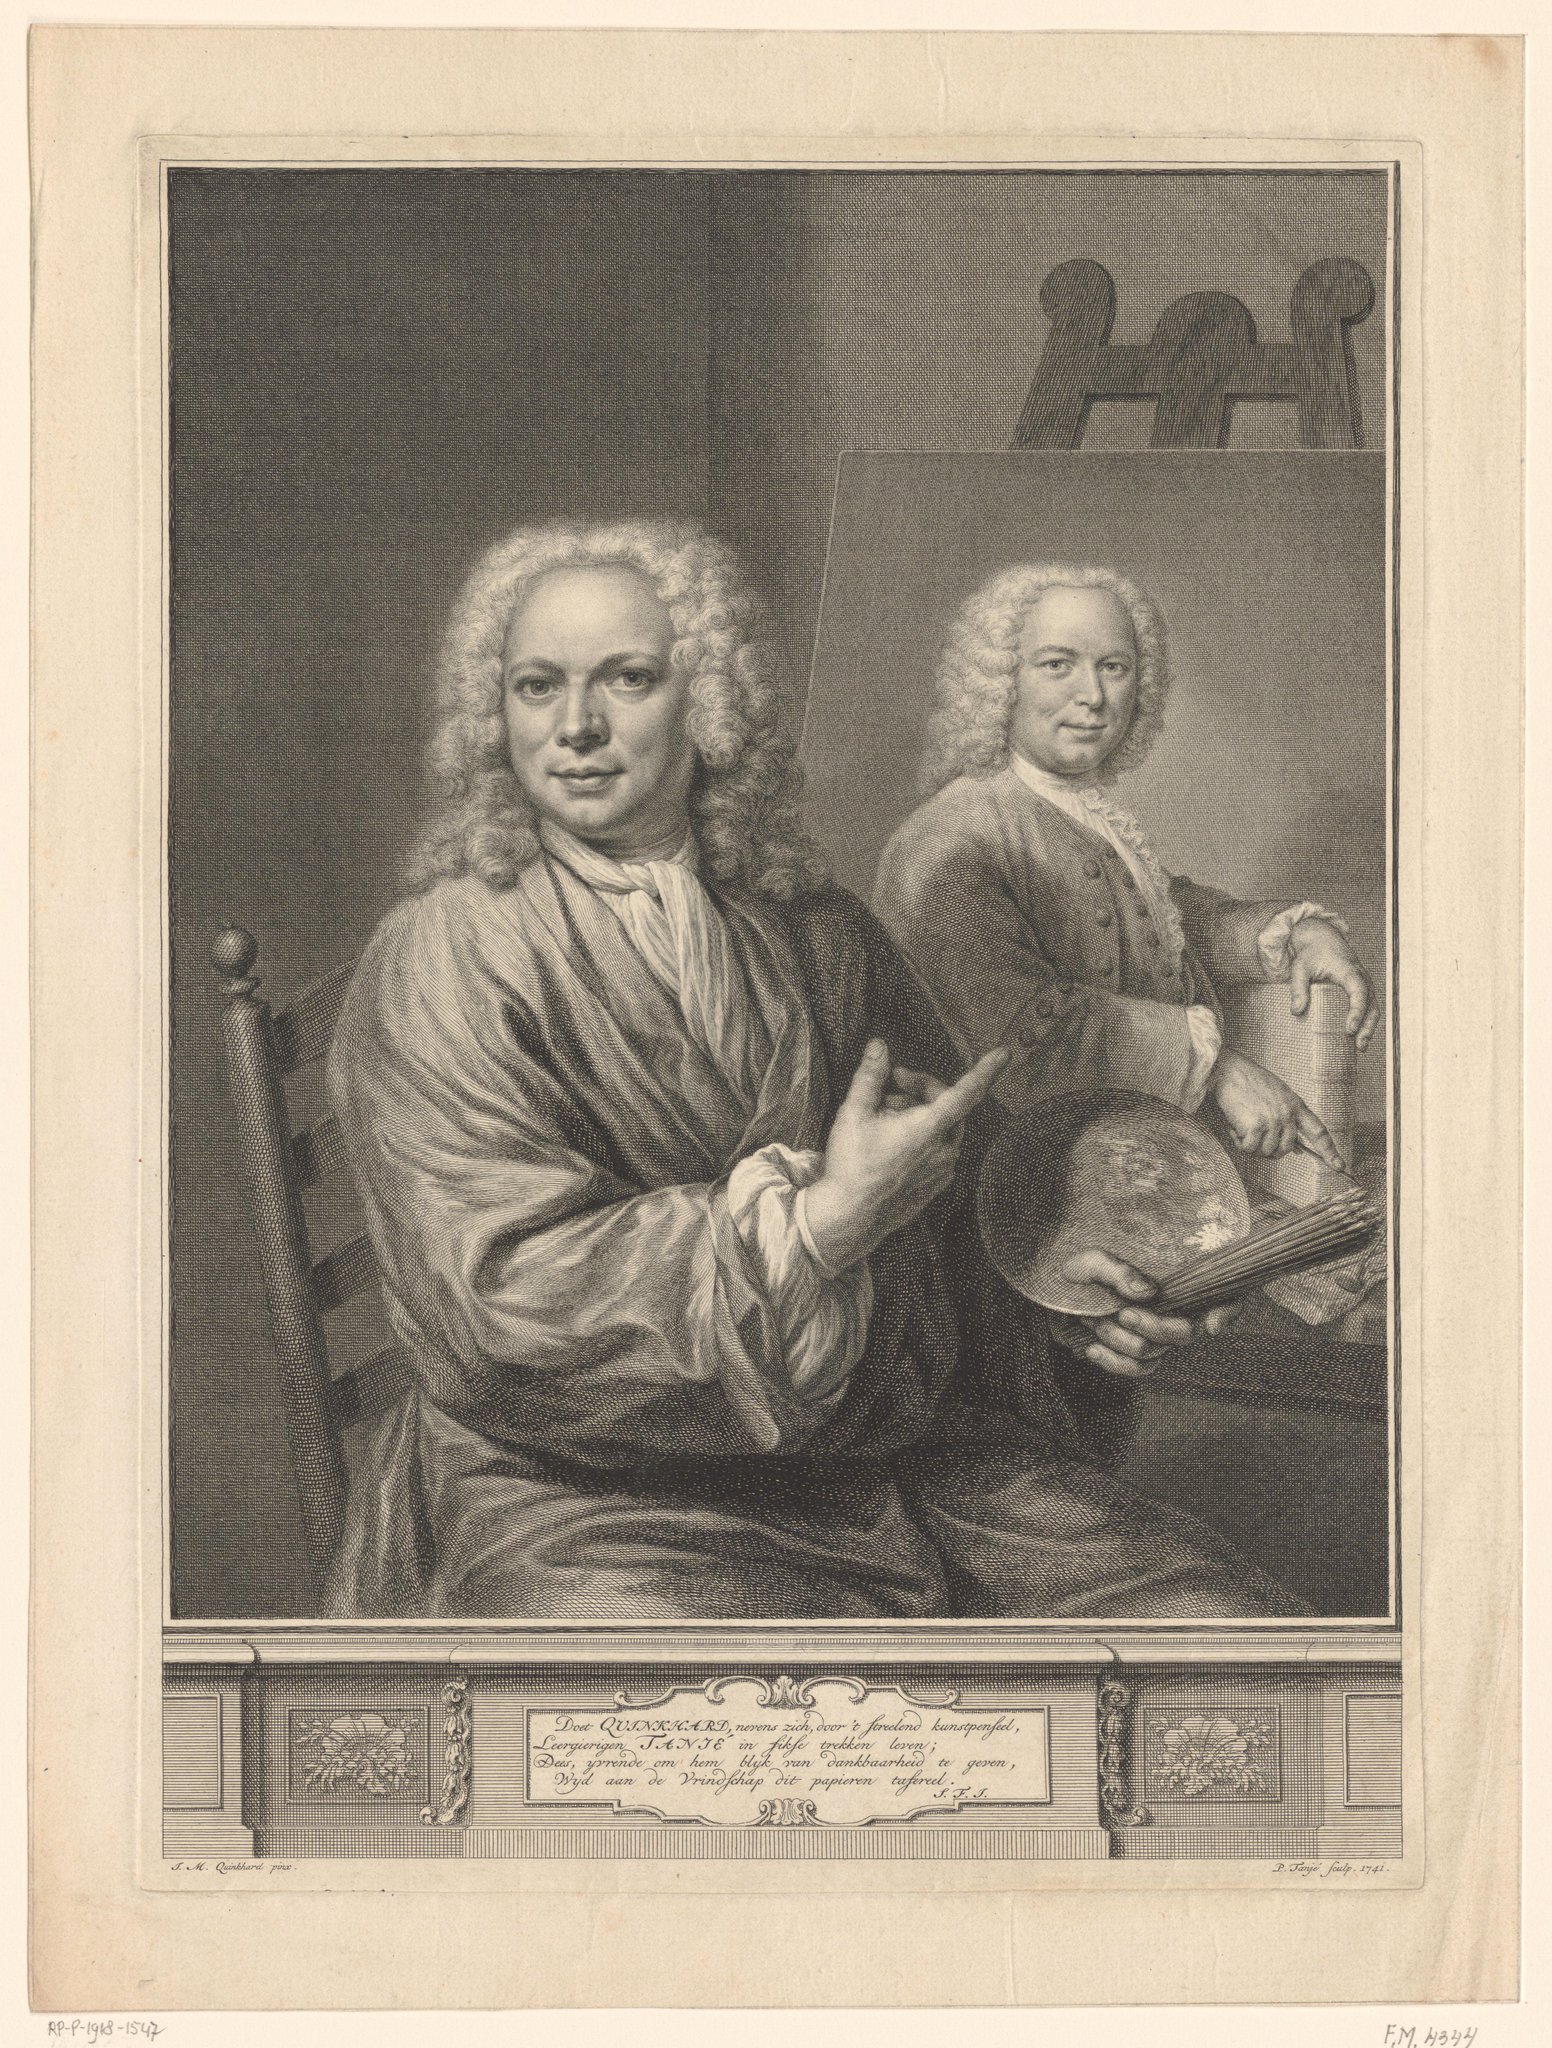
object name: print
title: Portretten van Jan Maurits Quinkhard en Pieter Tanjé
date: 1741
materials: paper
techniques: engraving, etching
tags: amsterdam, painter, draughtsman, jan maurits quinkhard, pieter tanjé, historical persons, portrait, self-portrait of painter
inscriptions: collector's mark: Lugt 2233, collector's mark: Lugt 2228